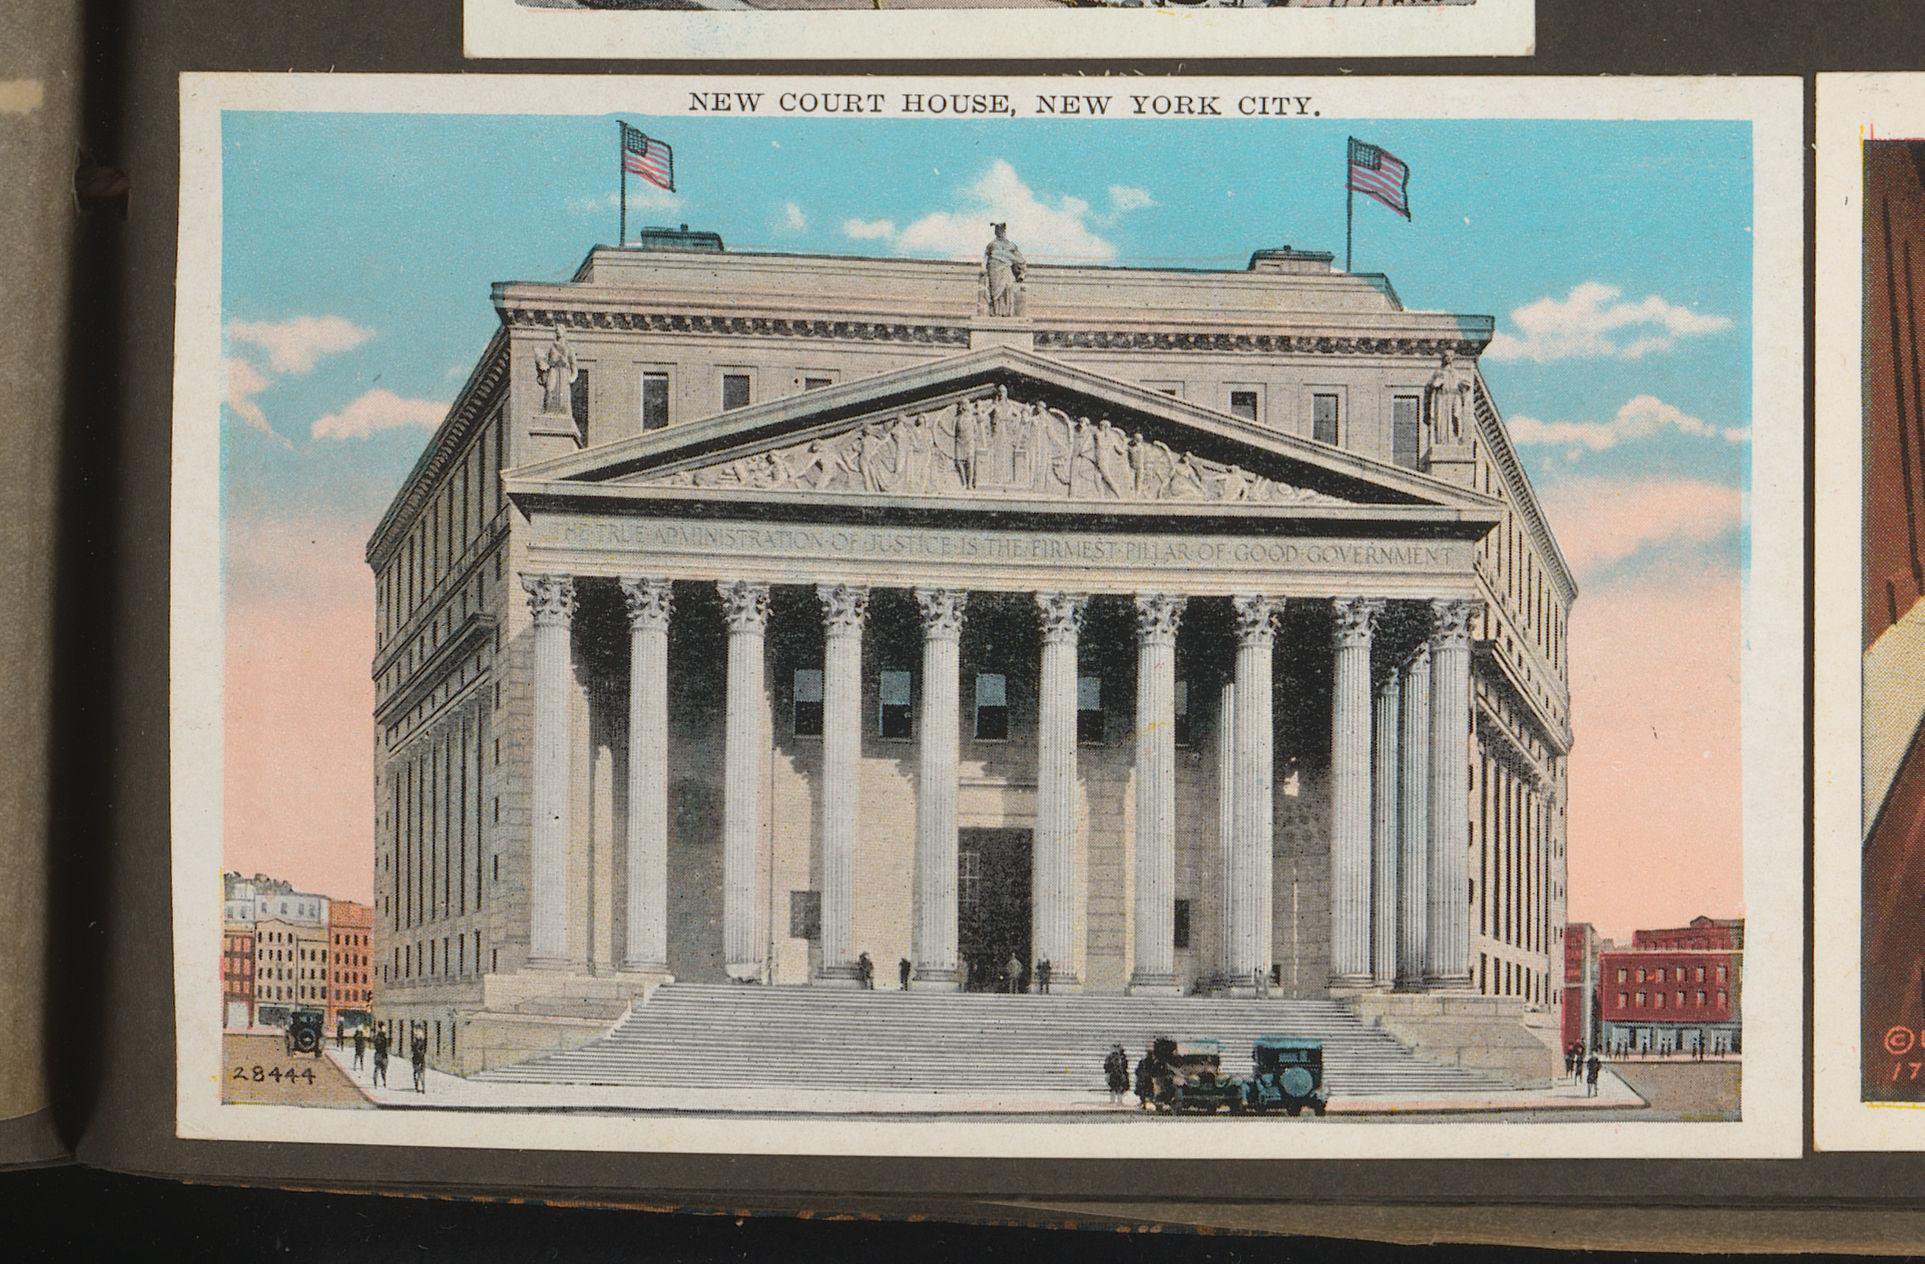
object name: ansichtkaart, prentbriefkaart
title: New court house, New York City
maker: Anonymous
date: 1928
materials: paper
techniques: four-color autotype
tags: court building, new york (city)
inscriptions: number: ‘28444’